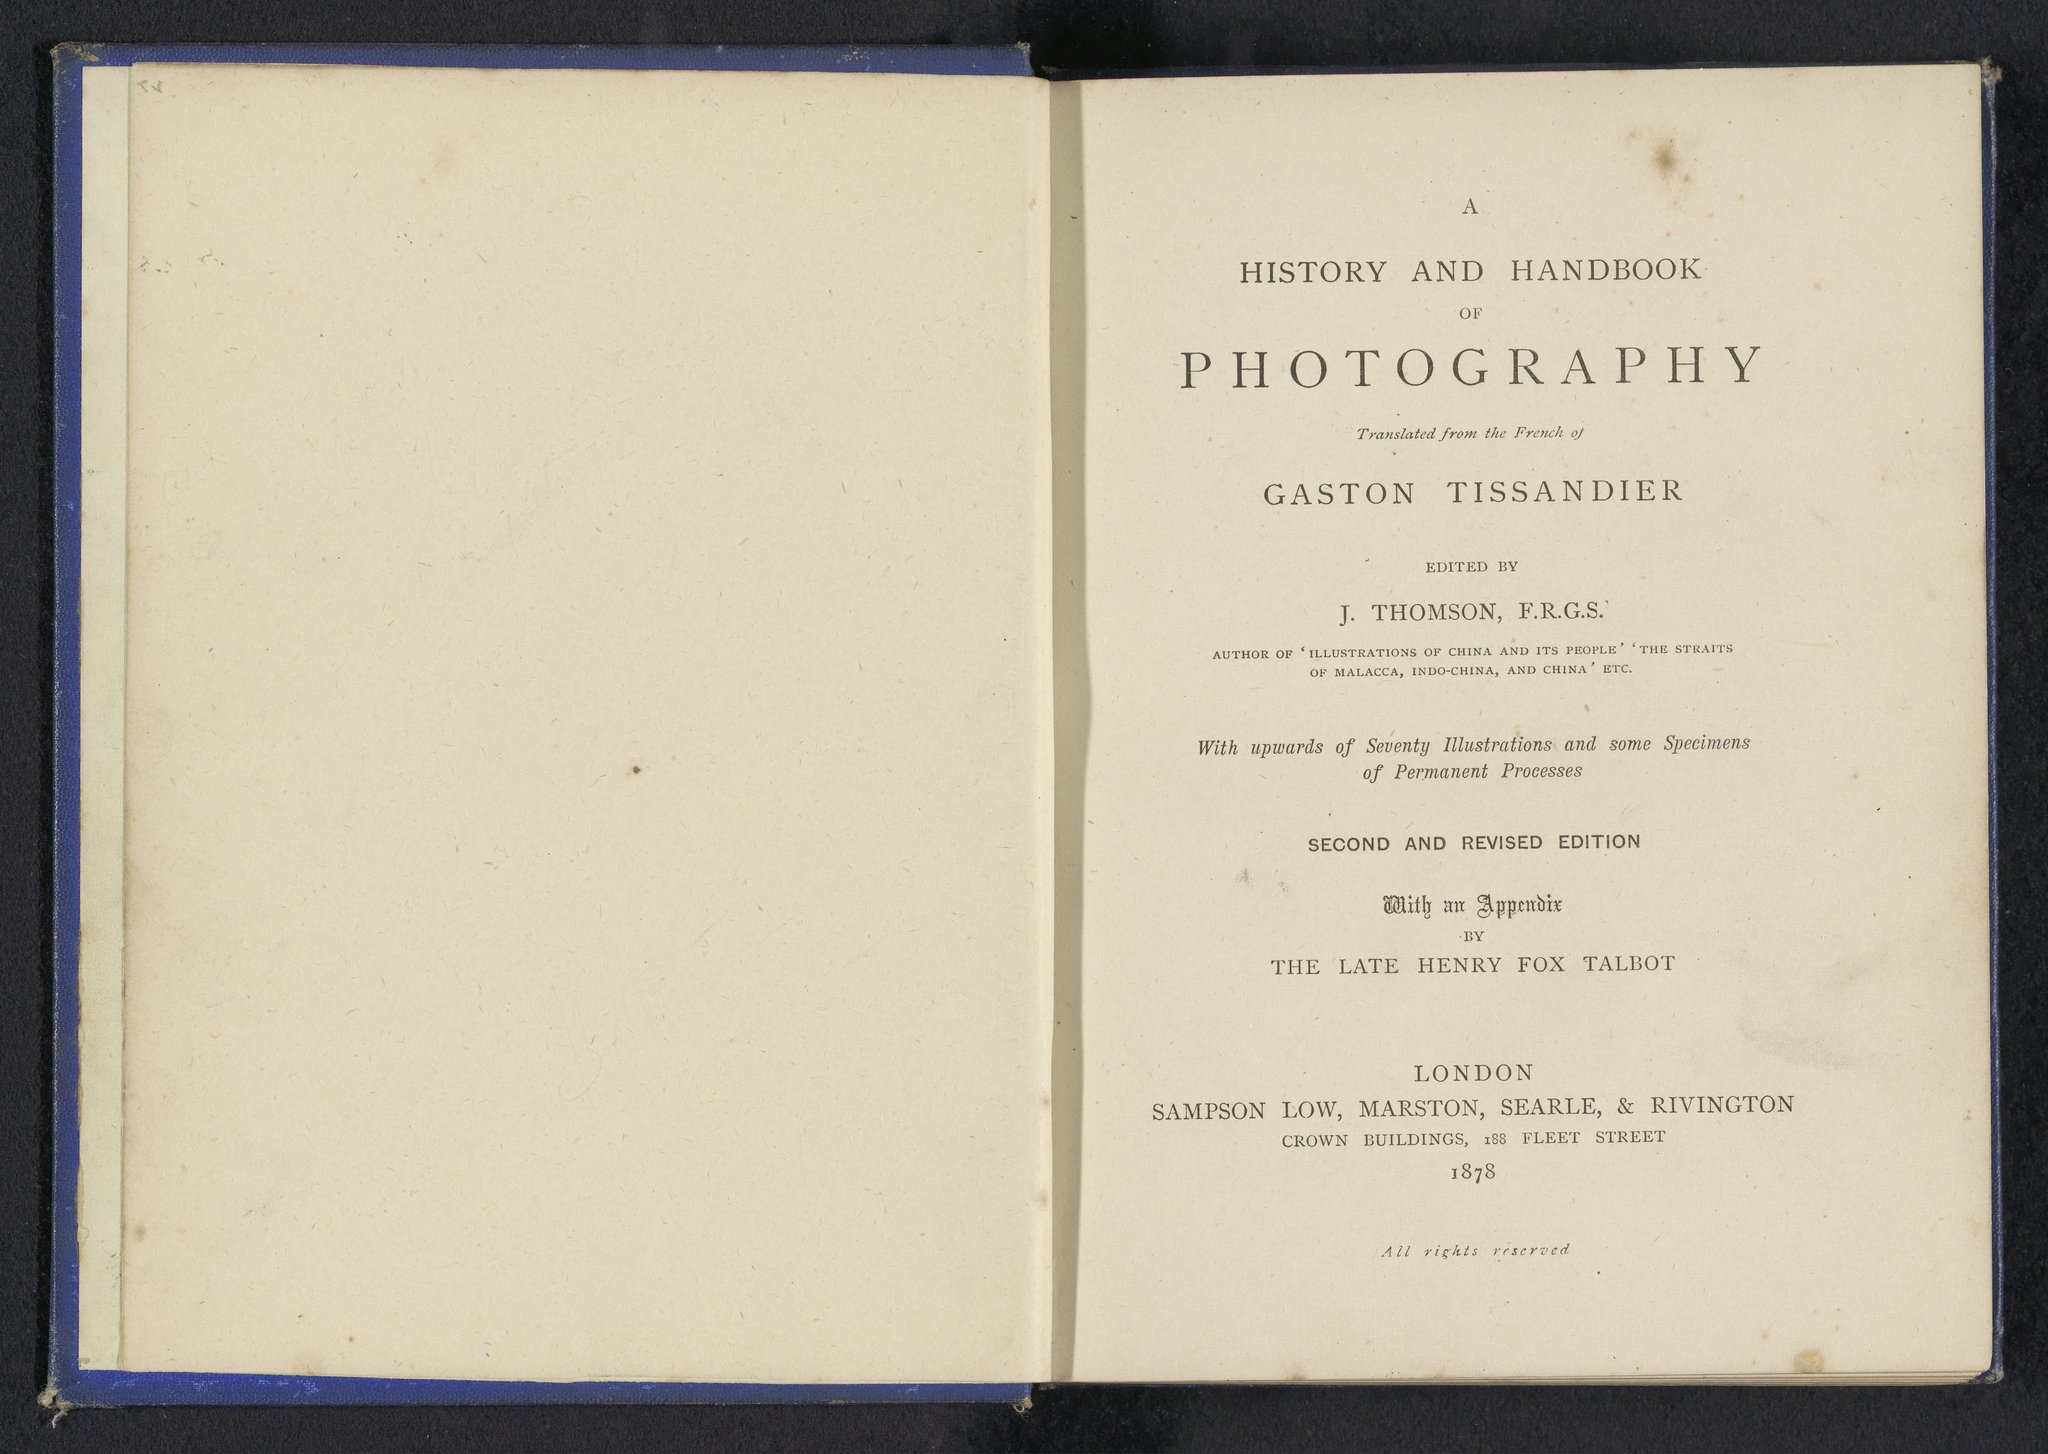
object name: book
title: A history and handbook of photography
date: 1878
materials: cardboard, linen, paper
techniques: photograph, photoaquatint, printing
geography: london